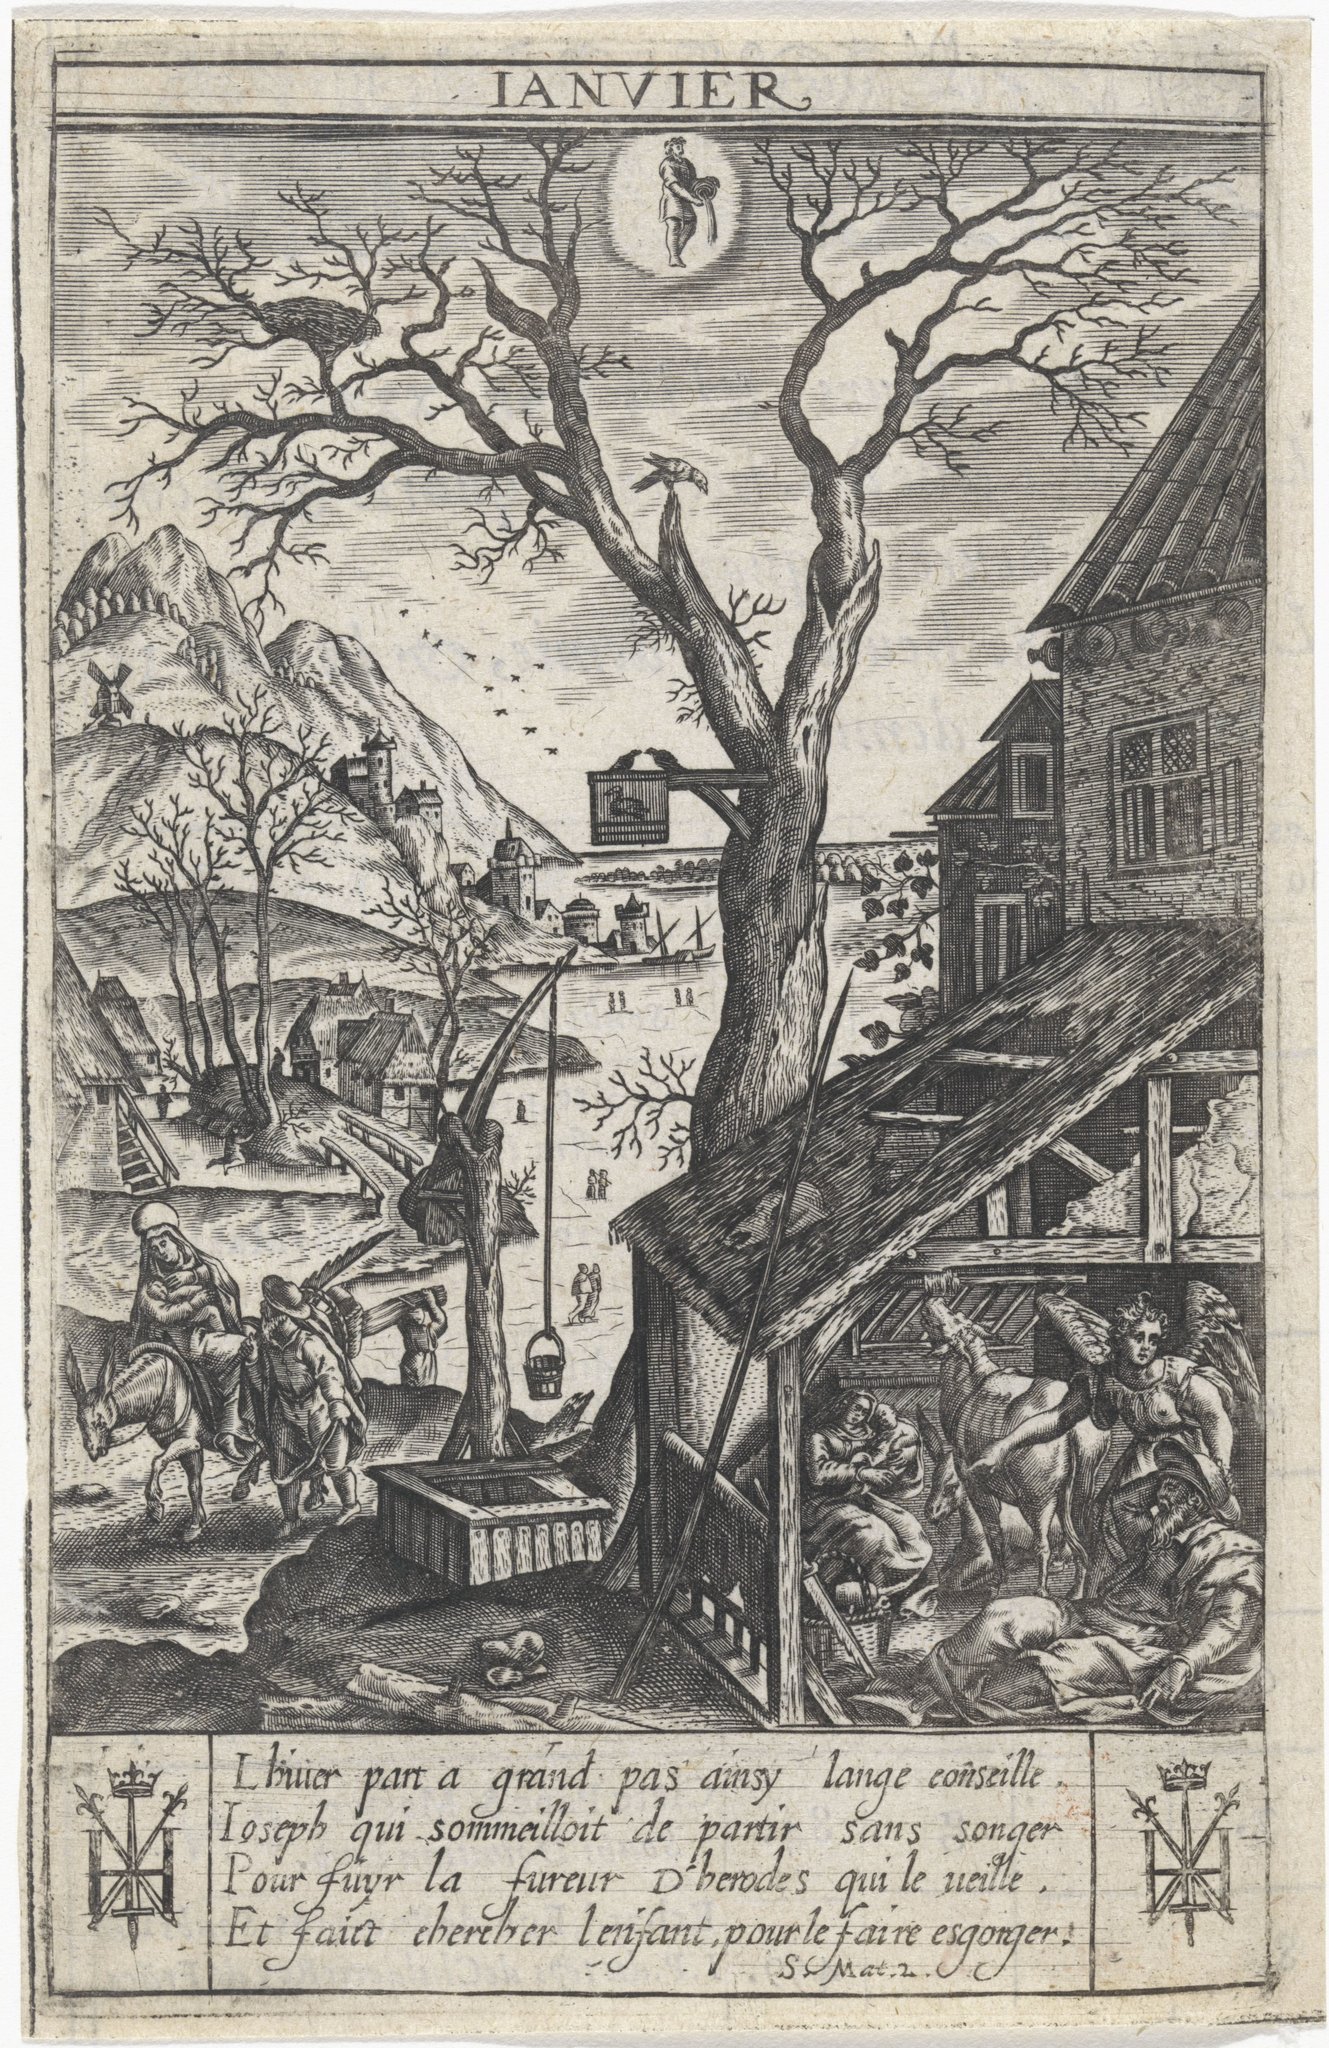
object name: print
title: Januari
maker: jan gerritsz swelinck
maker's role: print maker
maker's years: 1600-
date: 1624-1645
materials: paper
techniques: engraving, letterpress printing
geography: amsterdam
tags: the flight into egypt: mary, joseph, the child (and sometimes others) on their way; mary usually riding on an ass, an angel appearing to joseph in a dream summons him to flee into egypt, aquarius (zodiacal sign of january), landscape symbolizing january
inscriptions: collector's mark:, collector's mark: Lugt 2228, collector's mark: Lugt 2760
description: De maand Januari. In een winterlandschap met schaatsers leidt Jozef de ezel met daarop Maria en het Christuskind. In een aan een huis aangebouwde stal zit Maria met het Christuskind naast de os. De slapende Jozef krijgt in een droom van een engel te horen dat hij met zijn gezin naar Egypte moet vluchten om te ontkomen aan Herodes. In de lucht het symbool voor het sterrenbeeld Waterman. Onder de prent vier versregels in het Frans met een verwijzing naar Math. 2. Aan weerszijden van de tekst een drukkersmerk. Prent maakt deel uit van een serie met de maanden van het jaar, waarin scènes uit het Nieuwe Testament worden uitgebeeld. Op de achterzijde in rood en zwart een kalender van de betreffende maand in boekdruk.